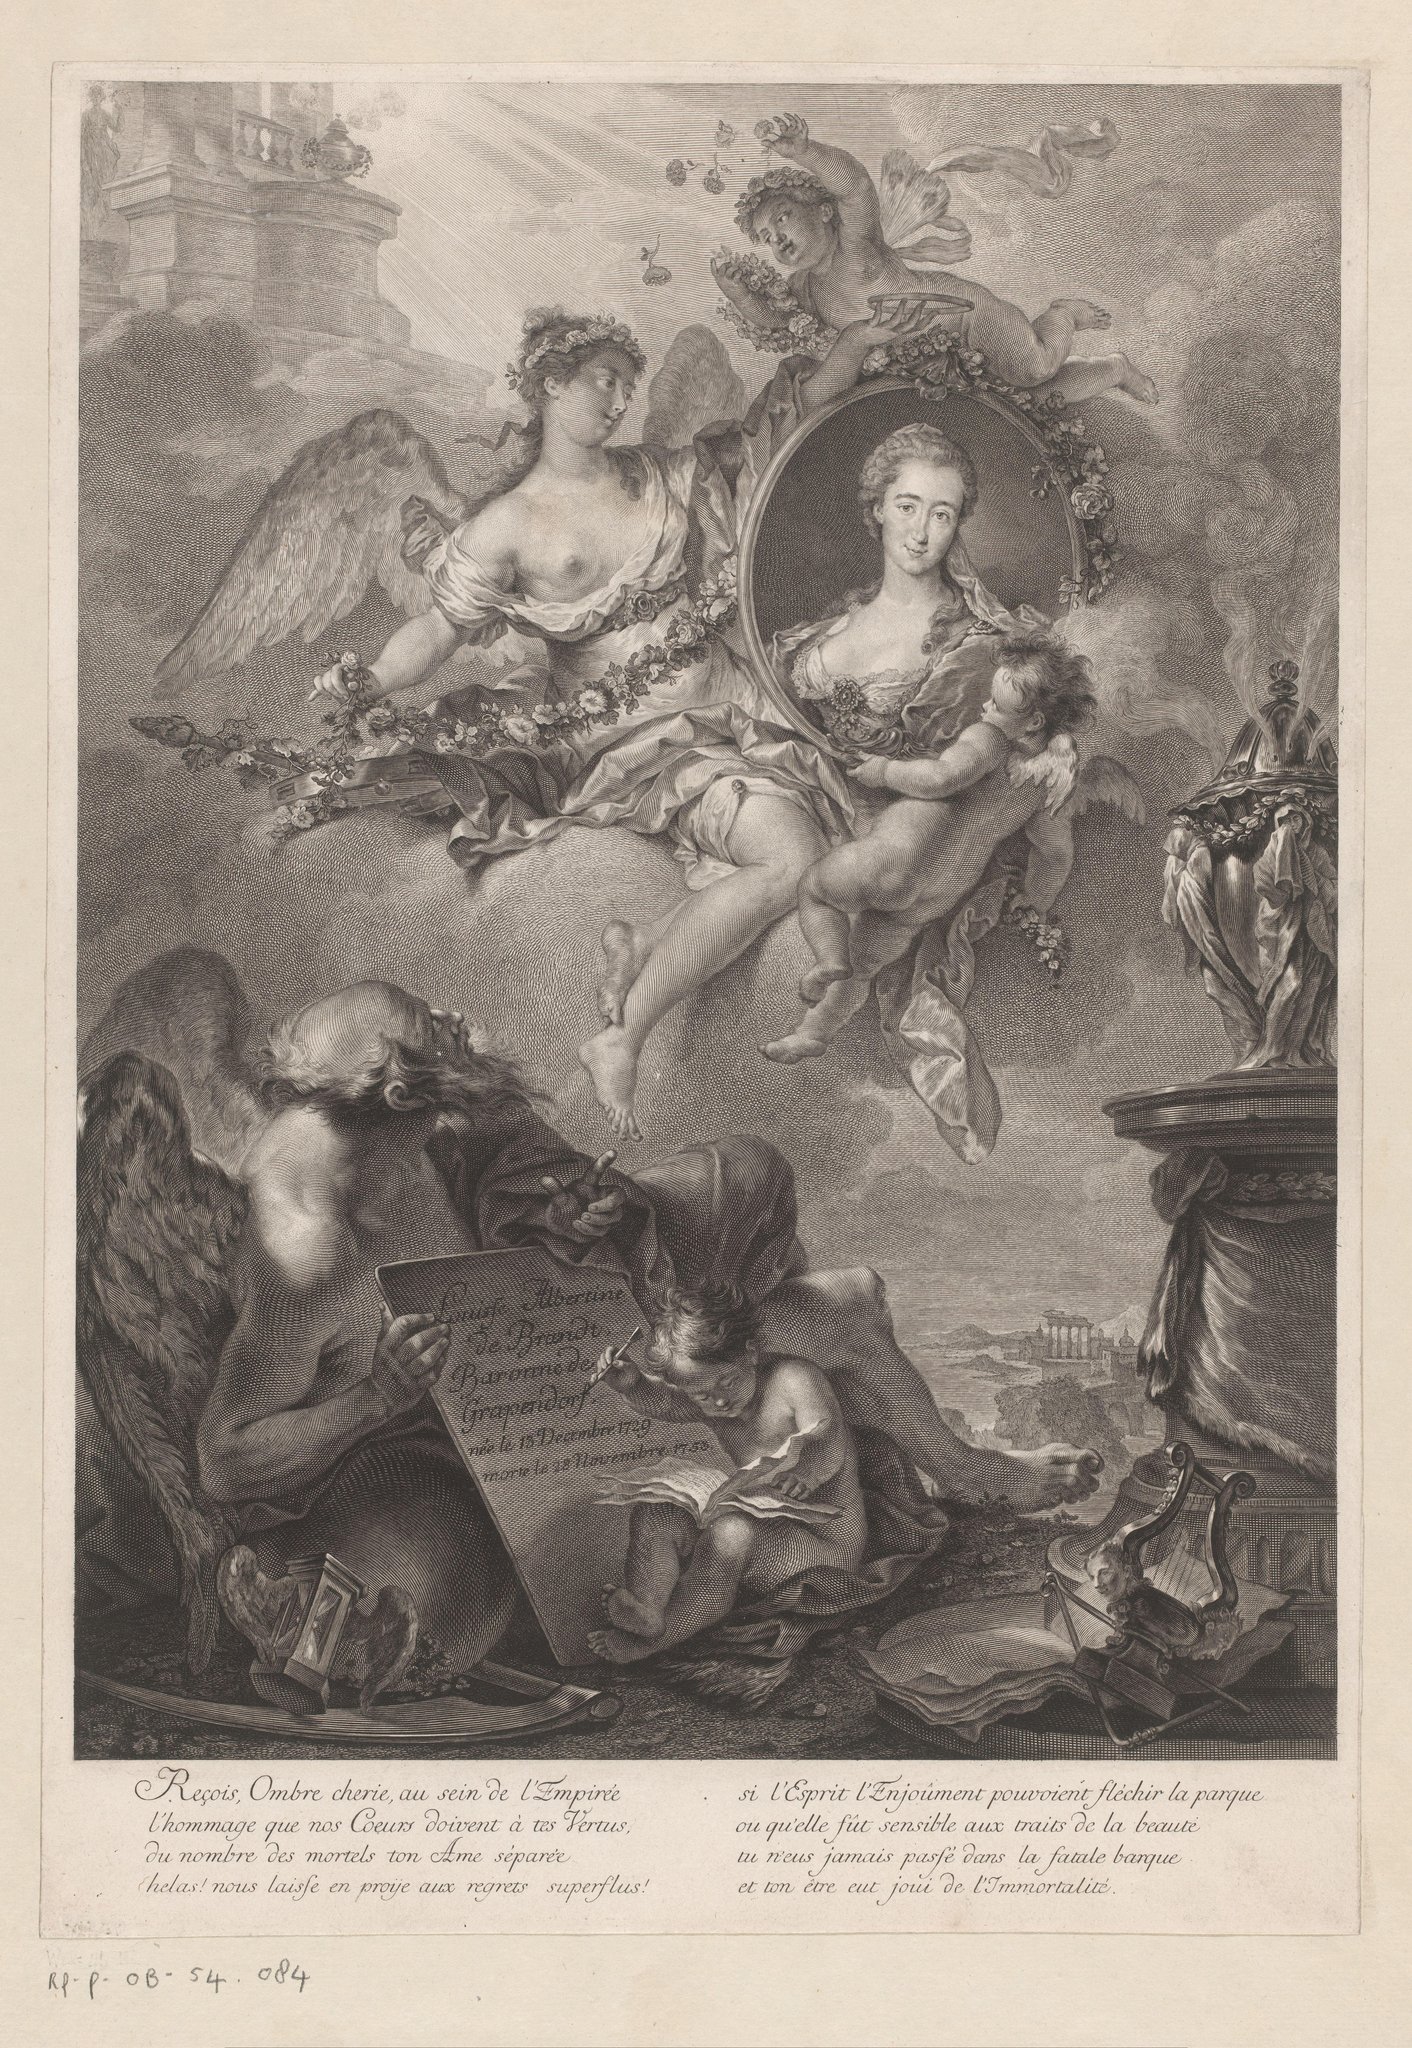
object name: print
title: Portret van Louise Albertine von Grapendorf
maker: georg friedrich schmidt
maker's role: draughtsman, print maker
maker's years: 1712-1775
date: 1753-1775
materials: paper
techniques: engraving, etching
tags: historical persons - bb - woman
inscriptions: collector's mark: Lugt 240